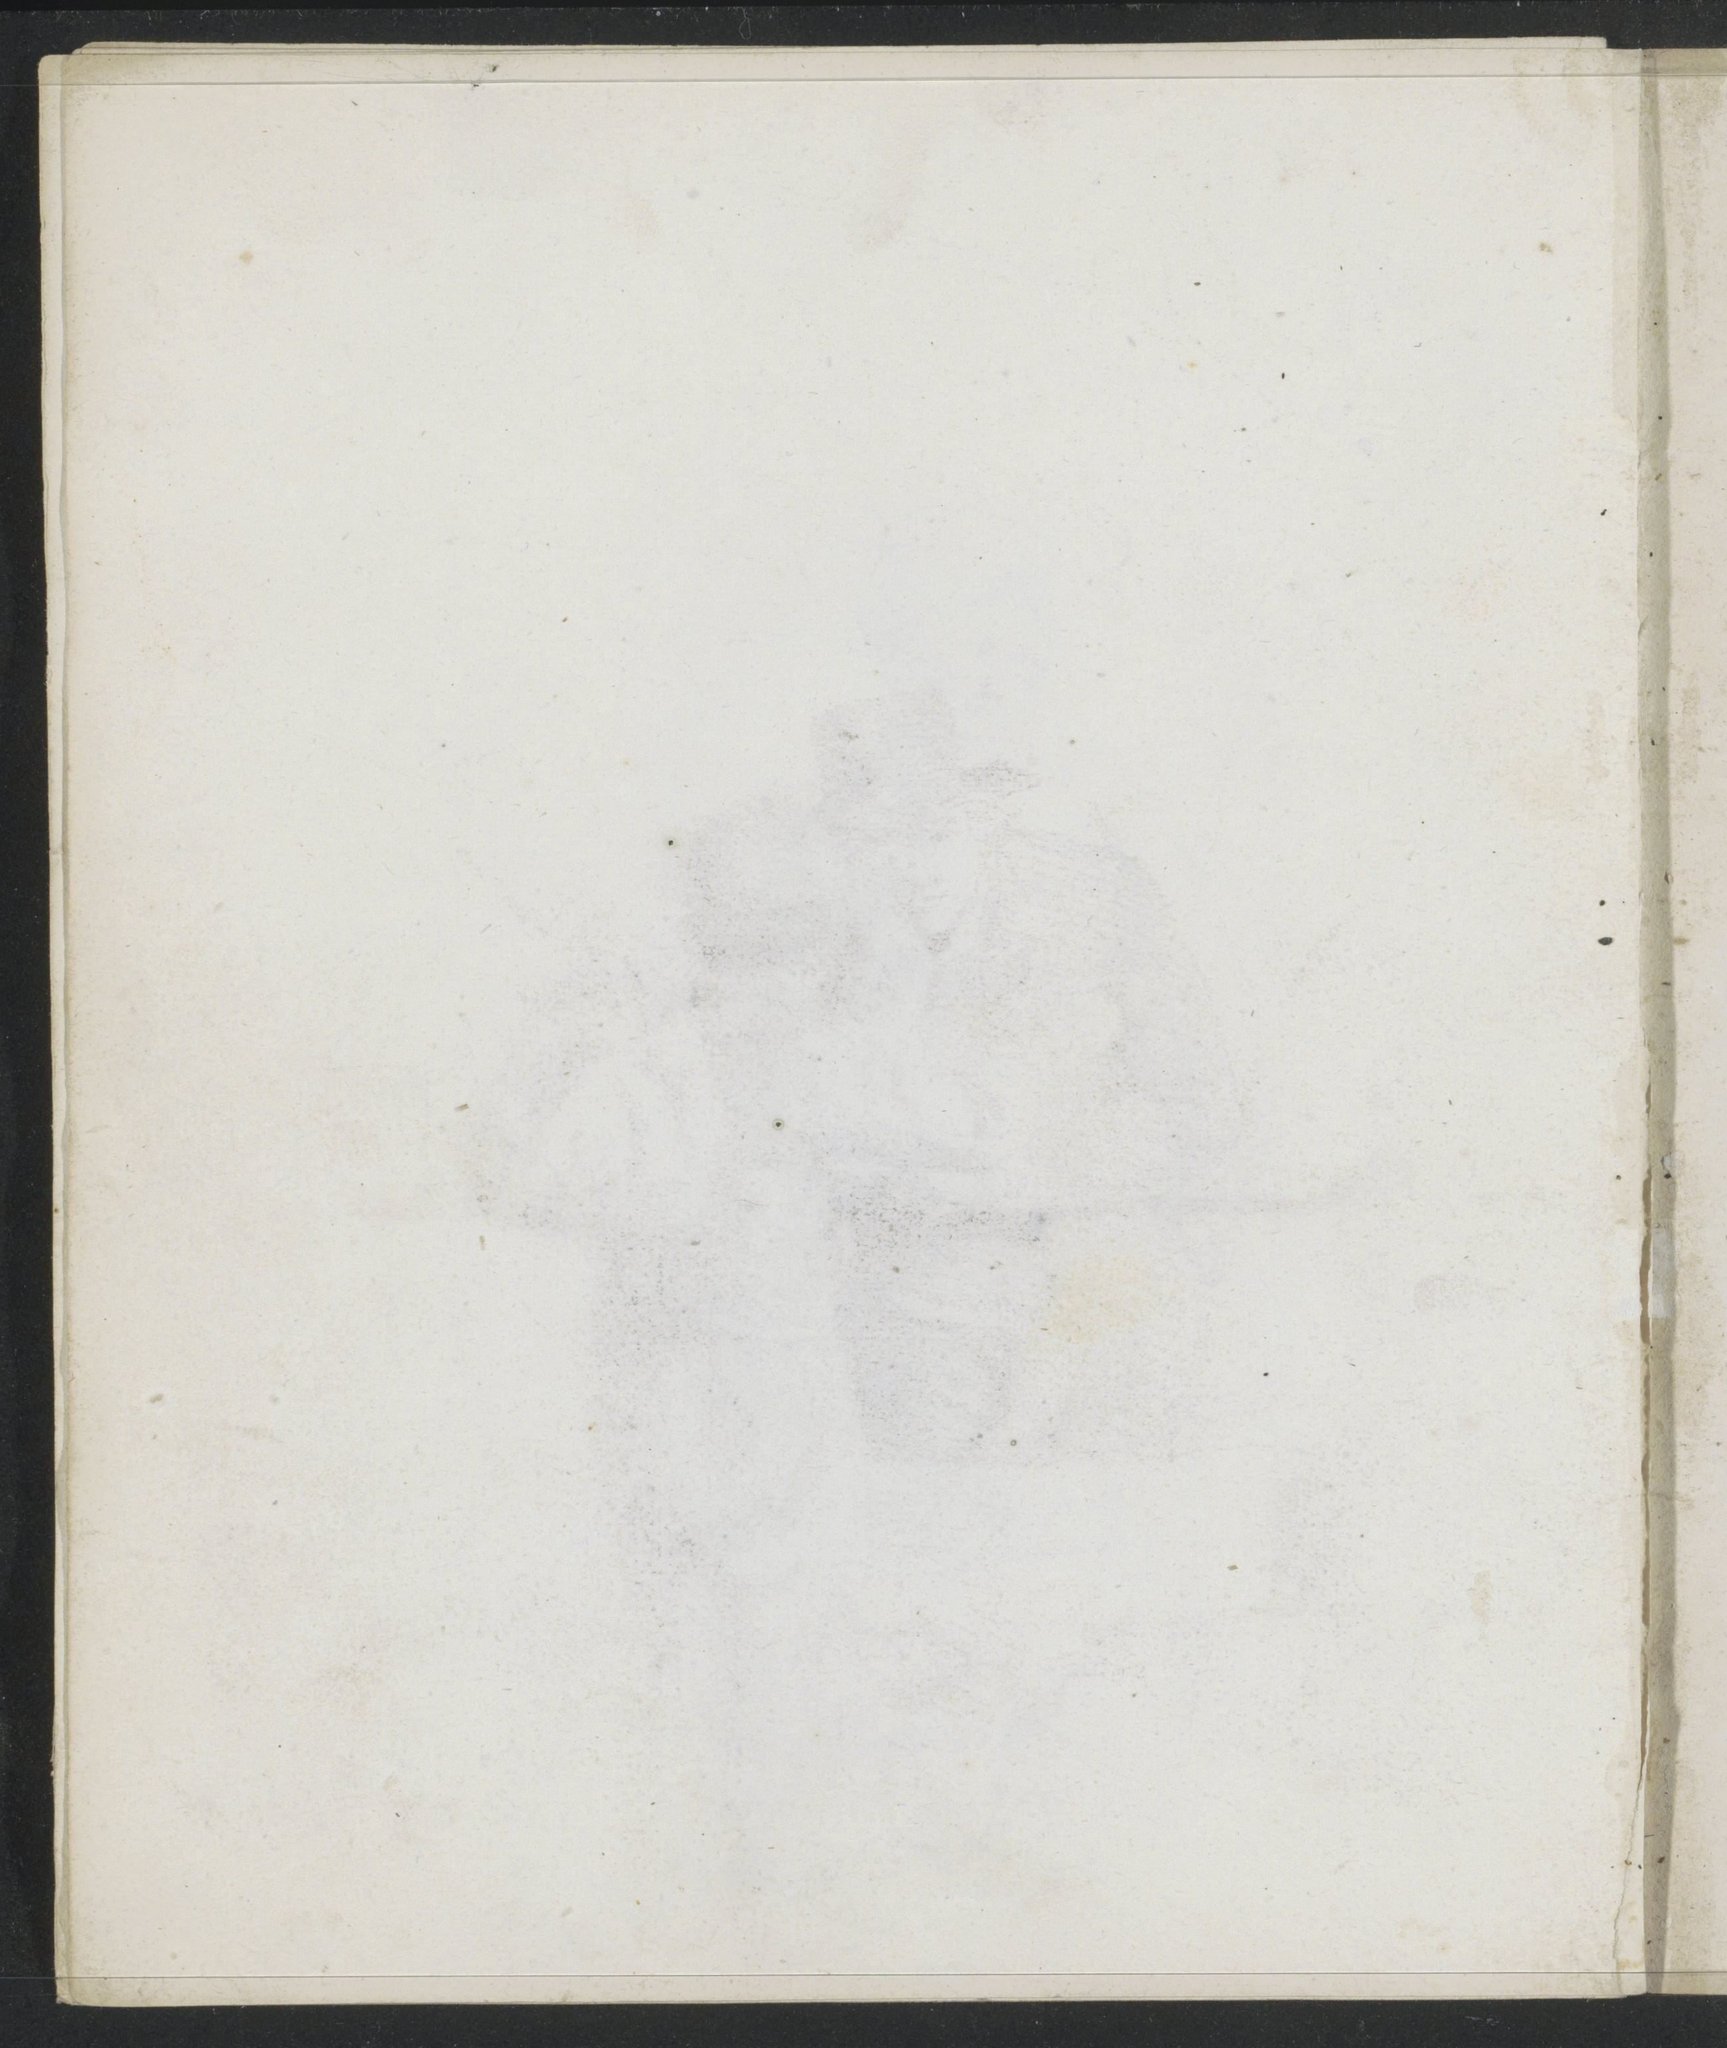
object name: sketchbook leaf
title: Abklatsch van een krijttekening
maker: balthasar paul ommeganck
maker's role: draughtsman, painter, print maker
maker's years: 1755-1826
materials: paper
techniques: printmaking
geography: antwerp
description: De studies van een man met hoge hoed en een jongen zijn niet langer aanwezig in het schetsboek. Blad 8 verso uit een schetsboek met 8 bladen.